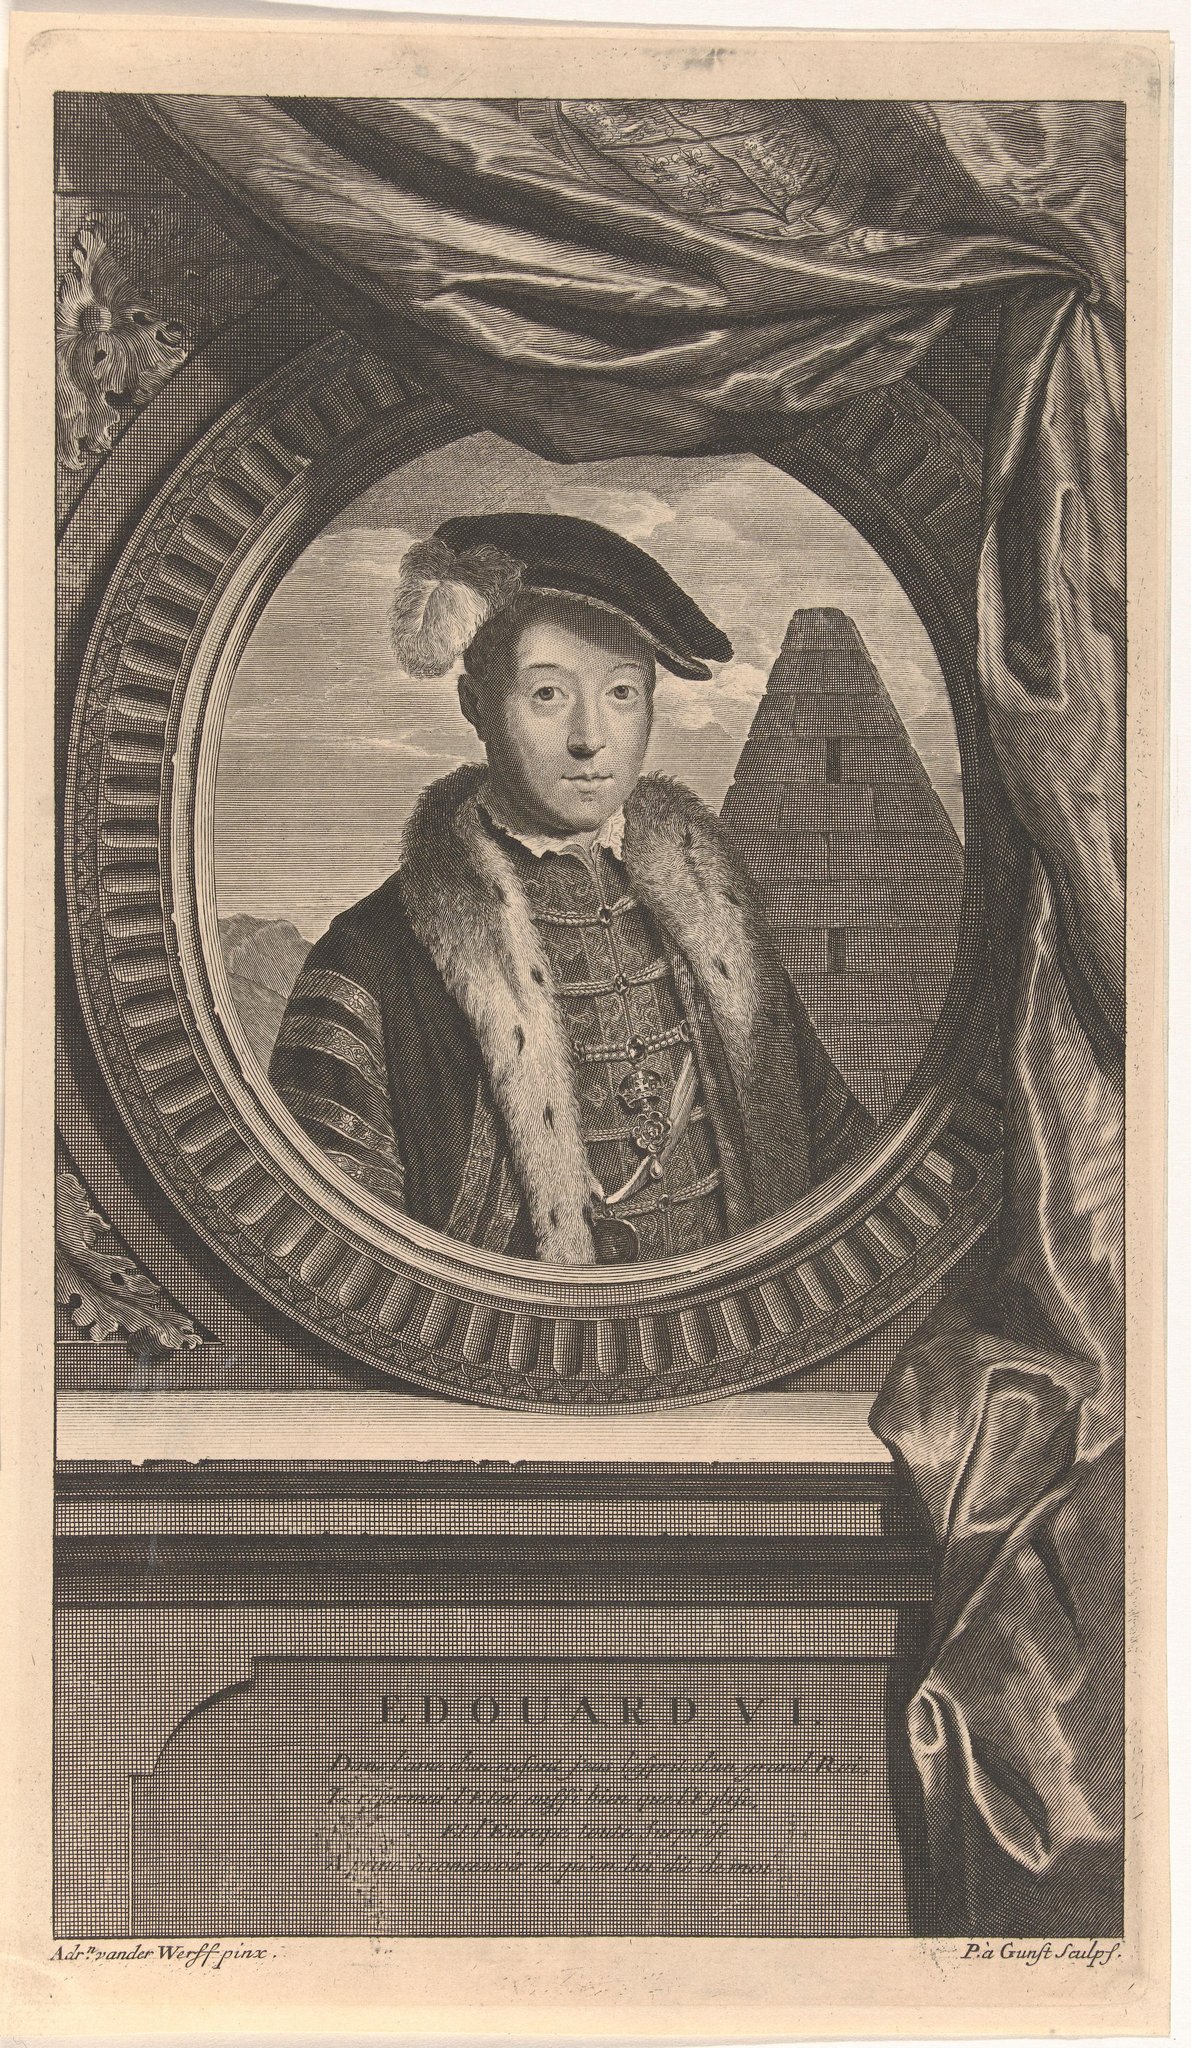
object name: print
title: Portret van koning Edward VI van Engeland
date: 1669-1731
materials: paper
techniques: engraving, etching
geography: amsterdam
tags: edward vi (koning van engeland)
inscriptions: collector's mark: Lugt 2228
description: Edward VI, koning van Engeland. Op de achtergrond een piramide. De prent heeft als onderschrift een Frans gedicht over zijn leven.